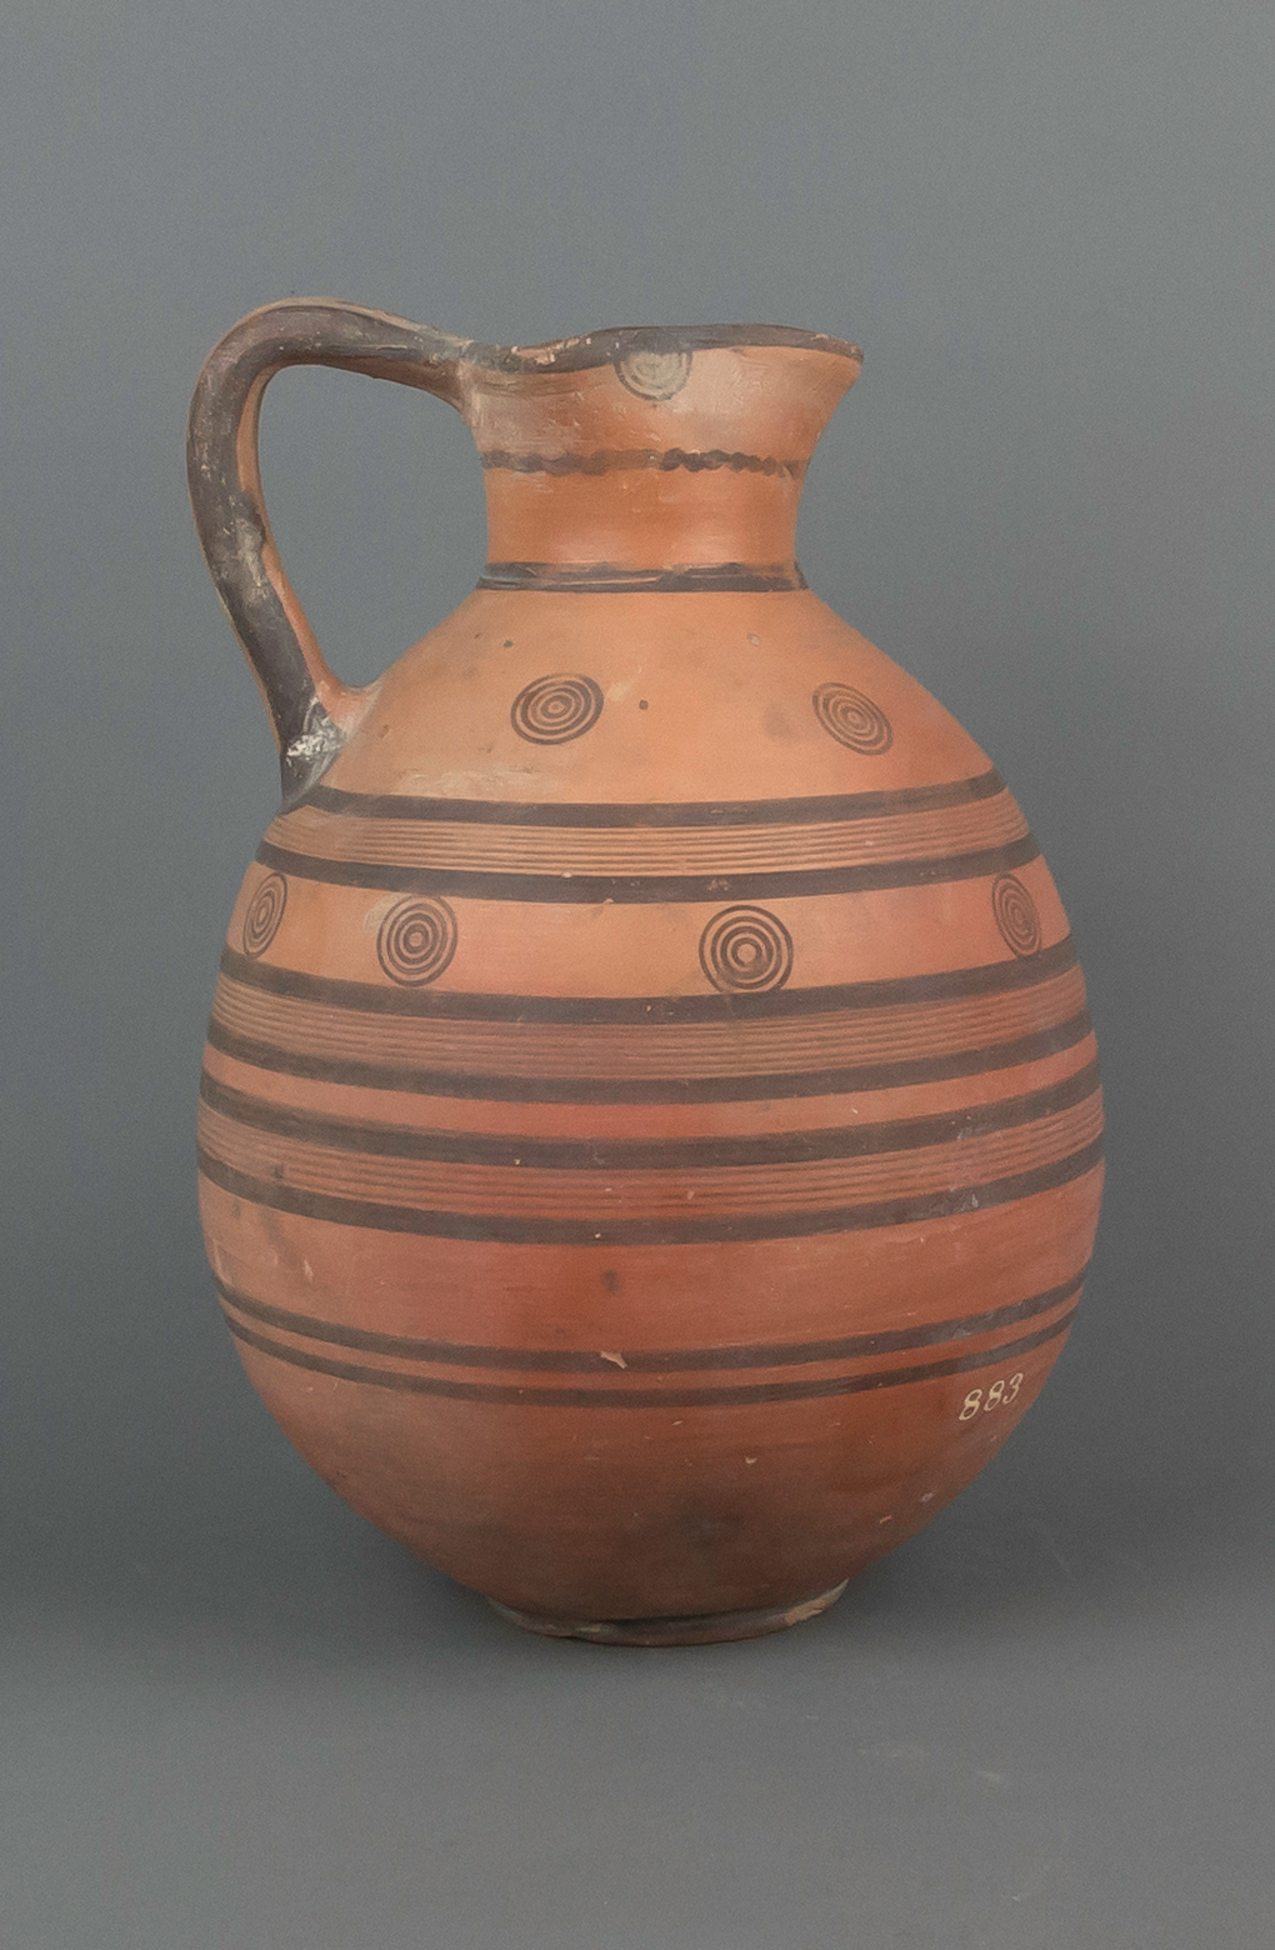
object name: juglet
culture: cypriot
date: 750-600 BCE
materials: terracotta